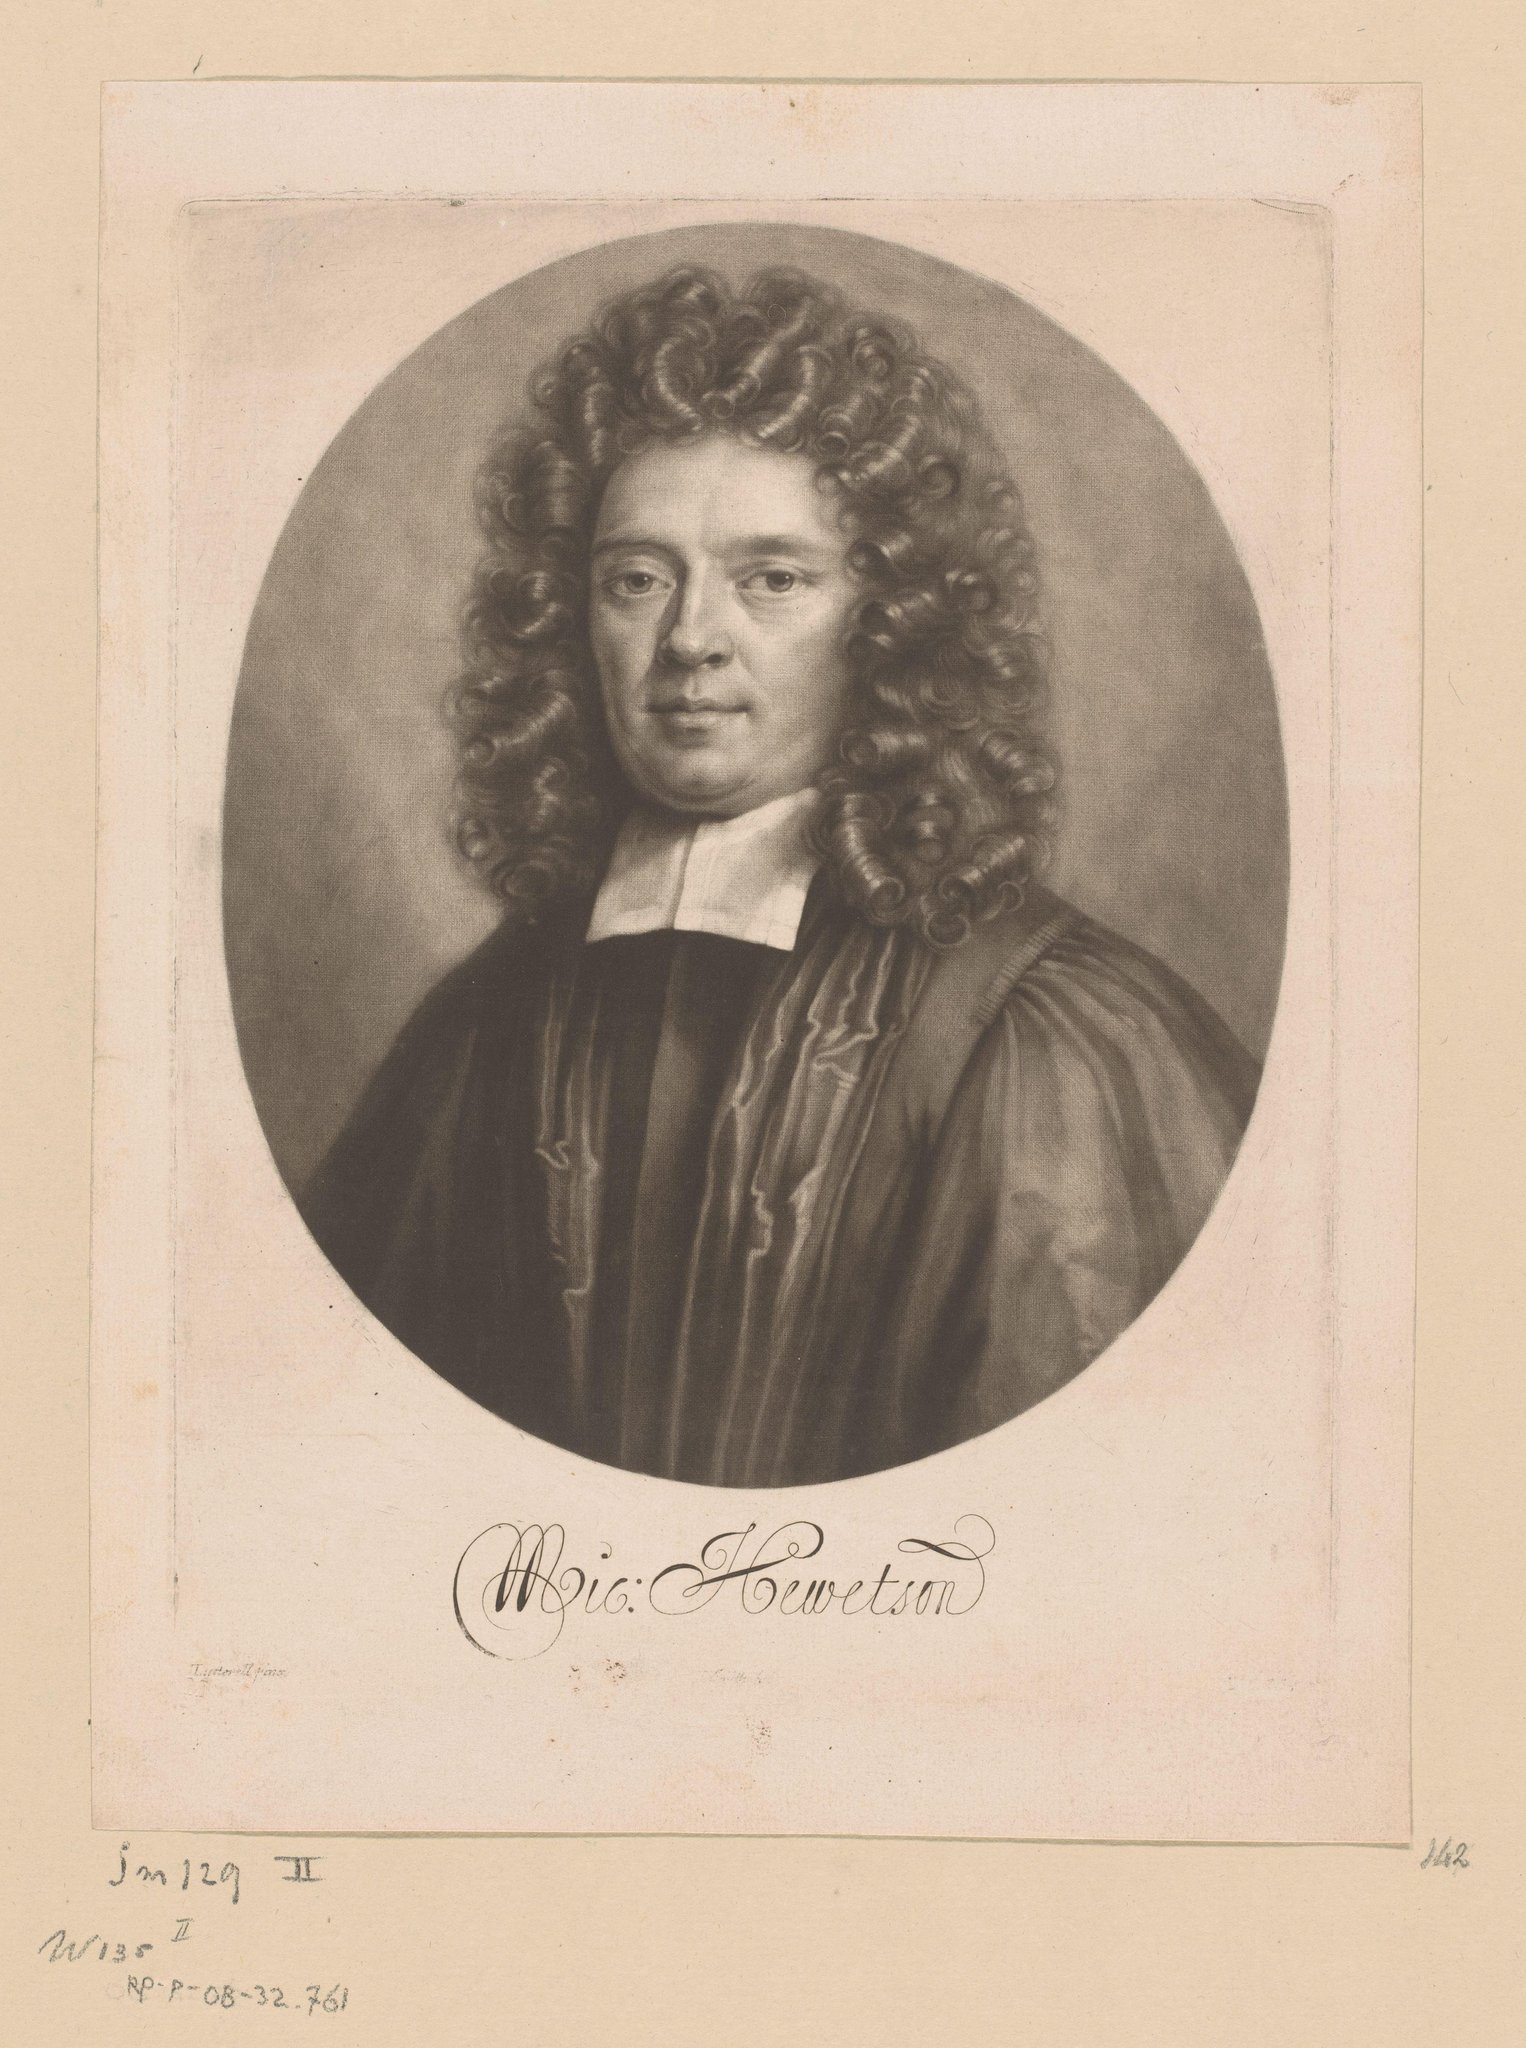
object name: print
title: Portret van Michael Hewetson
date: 1662-1742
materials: paper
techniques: mezzotint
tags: historical persons, regular clerics, e.g. jesuits, redemptorists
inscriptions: collector's mark: Lugt 240, collector's mark: Lugt 1842